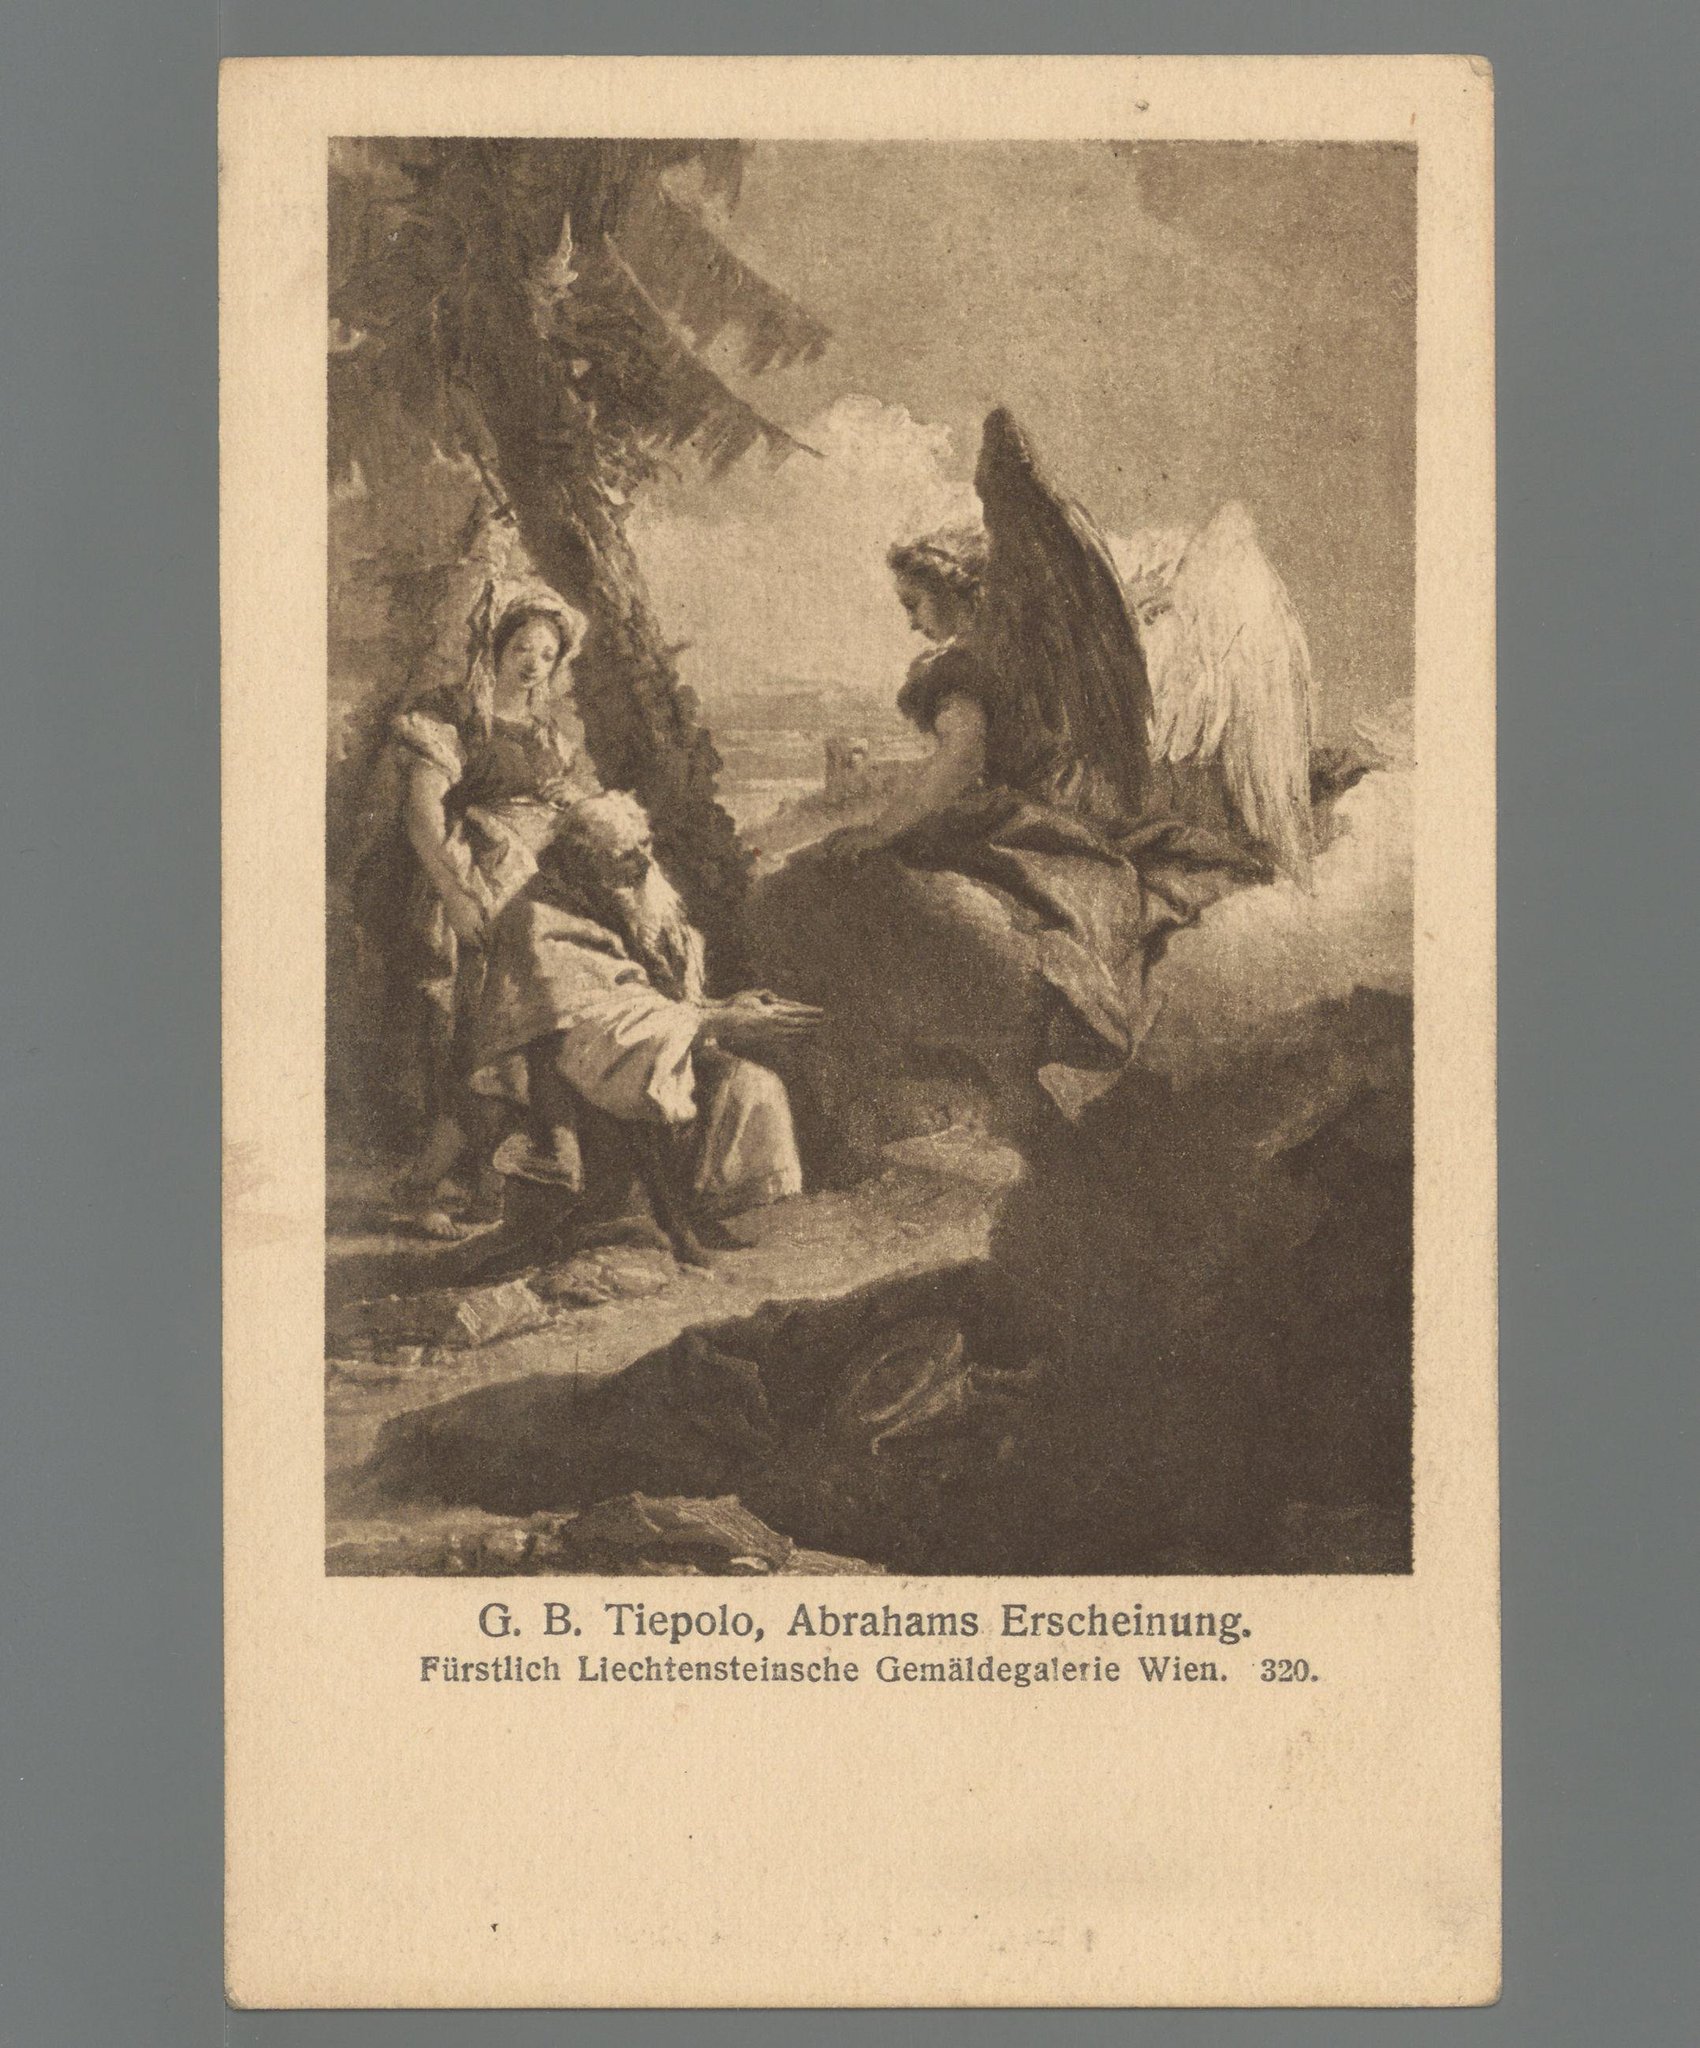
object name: ansichtkaart, prentbriefkaart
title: Abrahams Erscheinung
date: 1905-1930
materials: cardboard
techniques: rotogravure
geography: vienna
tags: story of abraham, angels